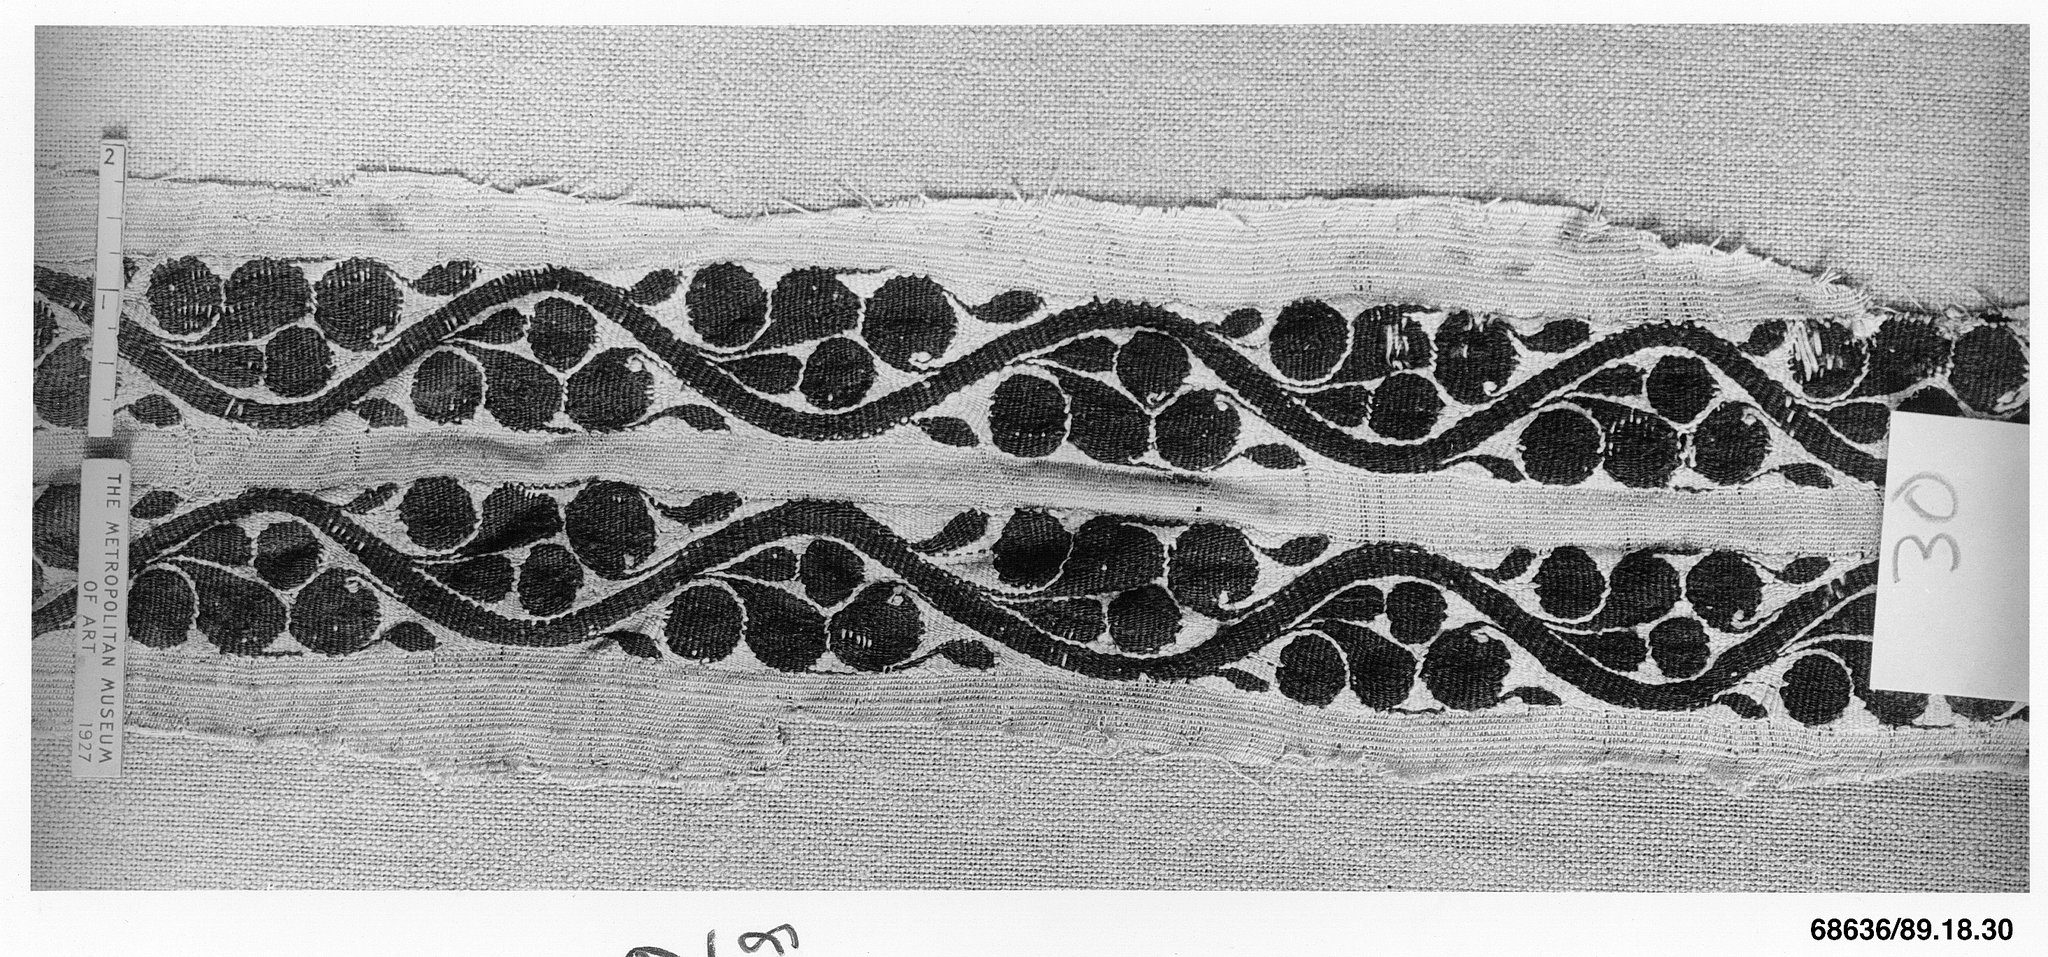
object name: textile fragment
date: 201-400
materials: linen, wool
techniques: weave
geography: egypt